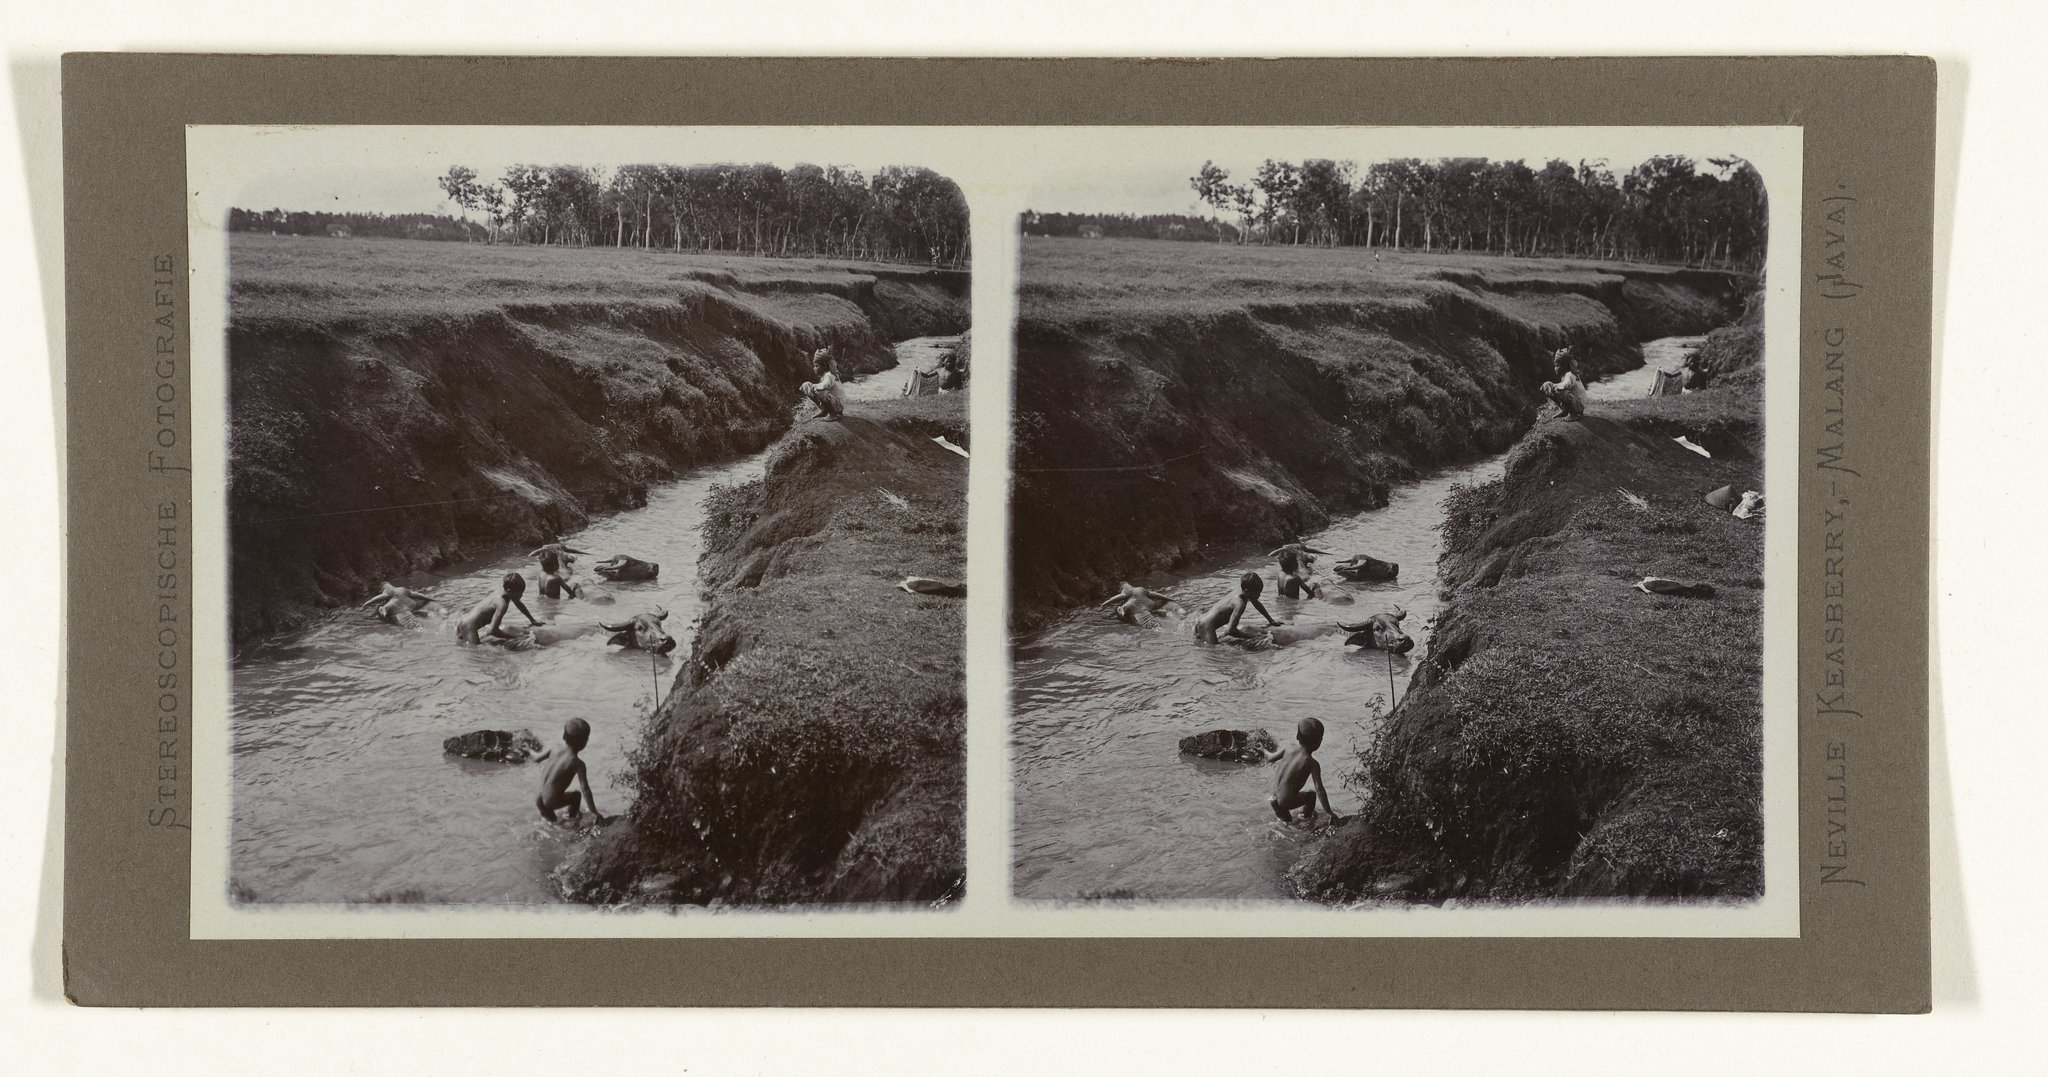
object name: stereograph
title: Jongens in de rivier bij badende karbouwen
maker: neville keasberry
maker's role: fotograaf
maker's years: 1866-1944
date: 1900-1935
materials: cardboard, paper, photographic support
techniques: albumen print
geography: malang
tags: west-java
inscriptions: signature: ‘Neville Keasberry, Malang (Java)’, inscription: ‘Stereoscopische Fotografie’